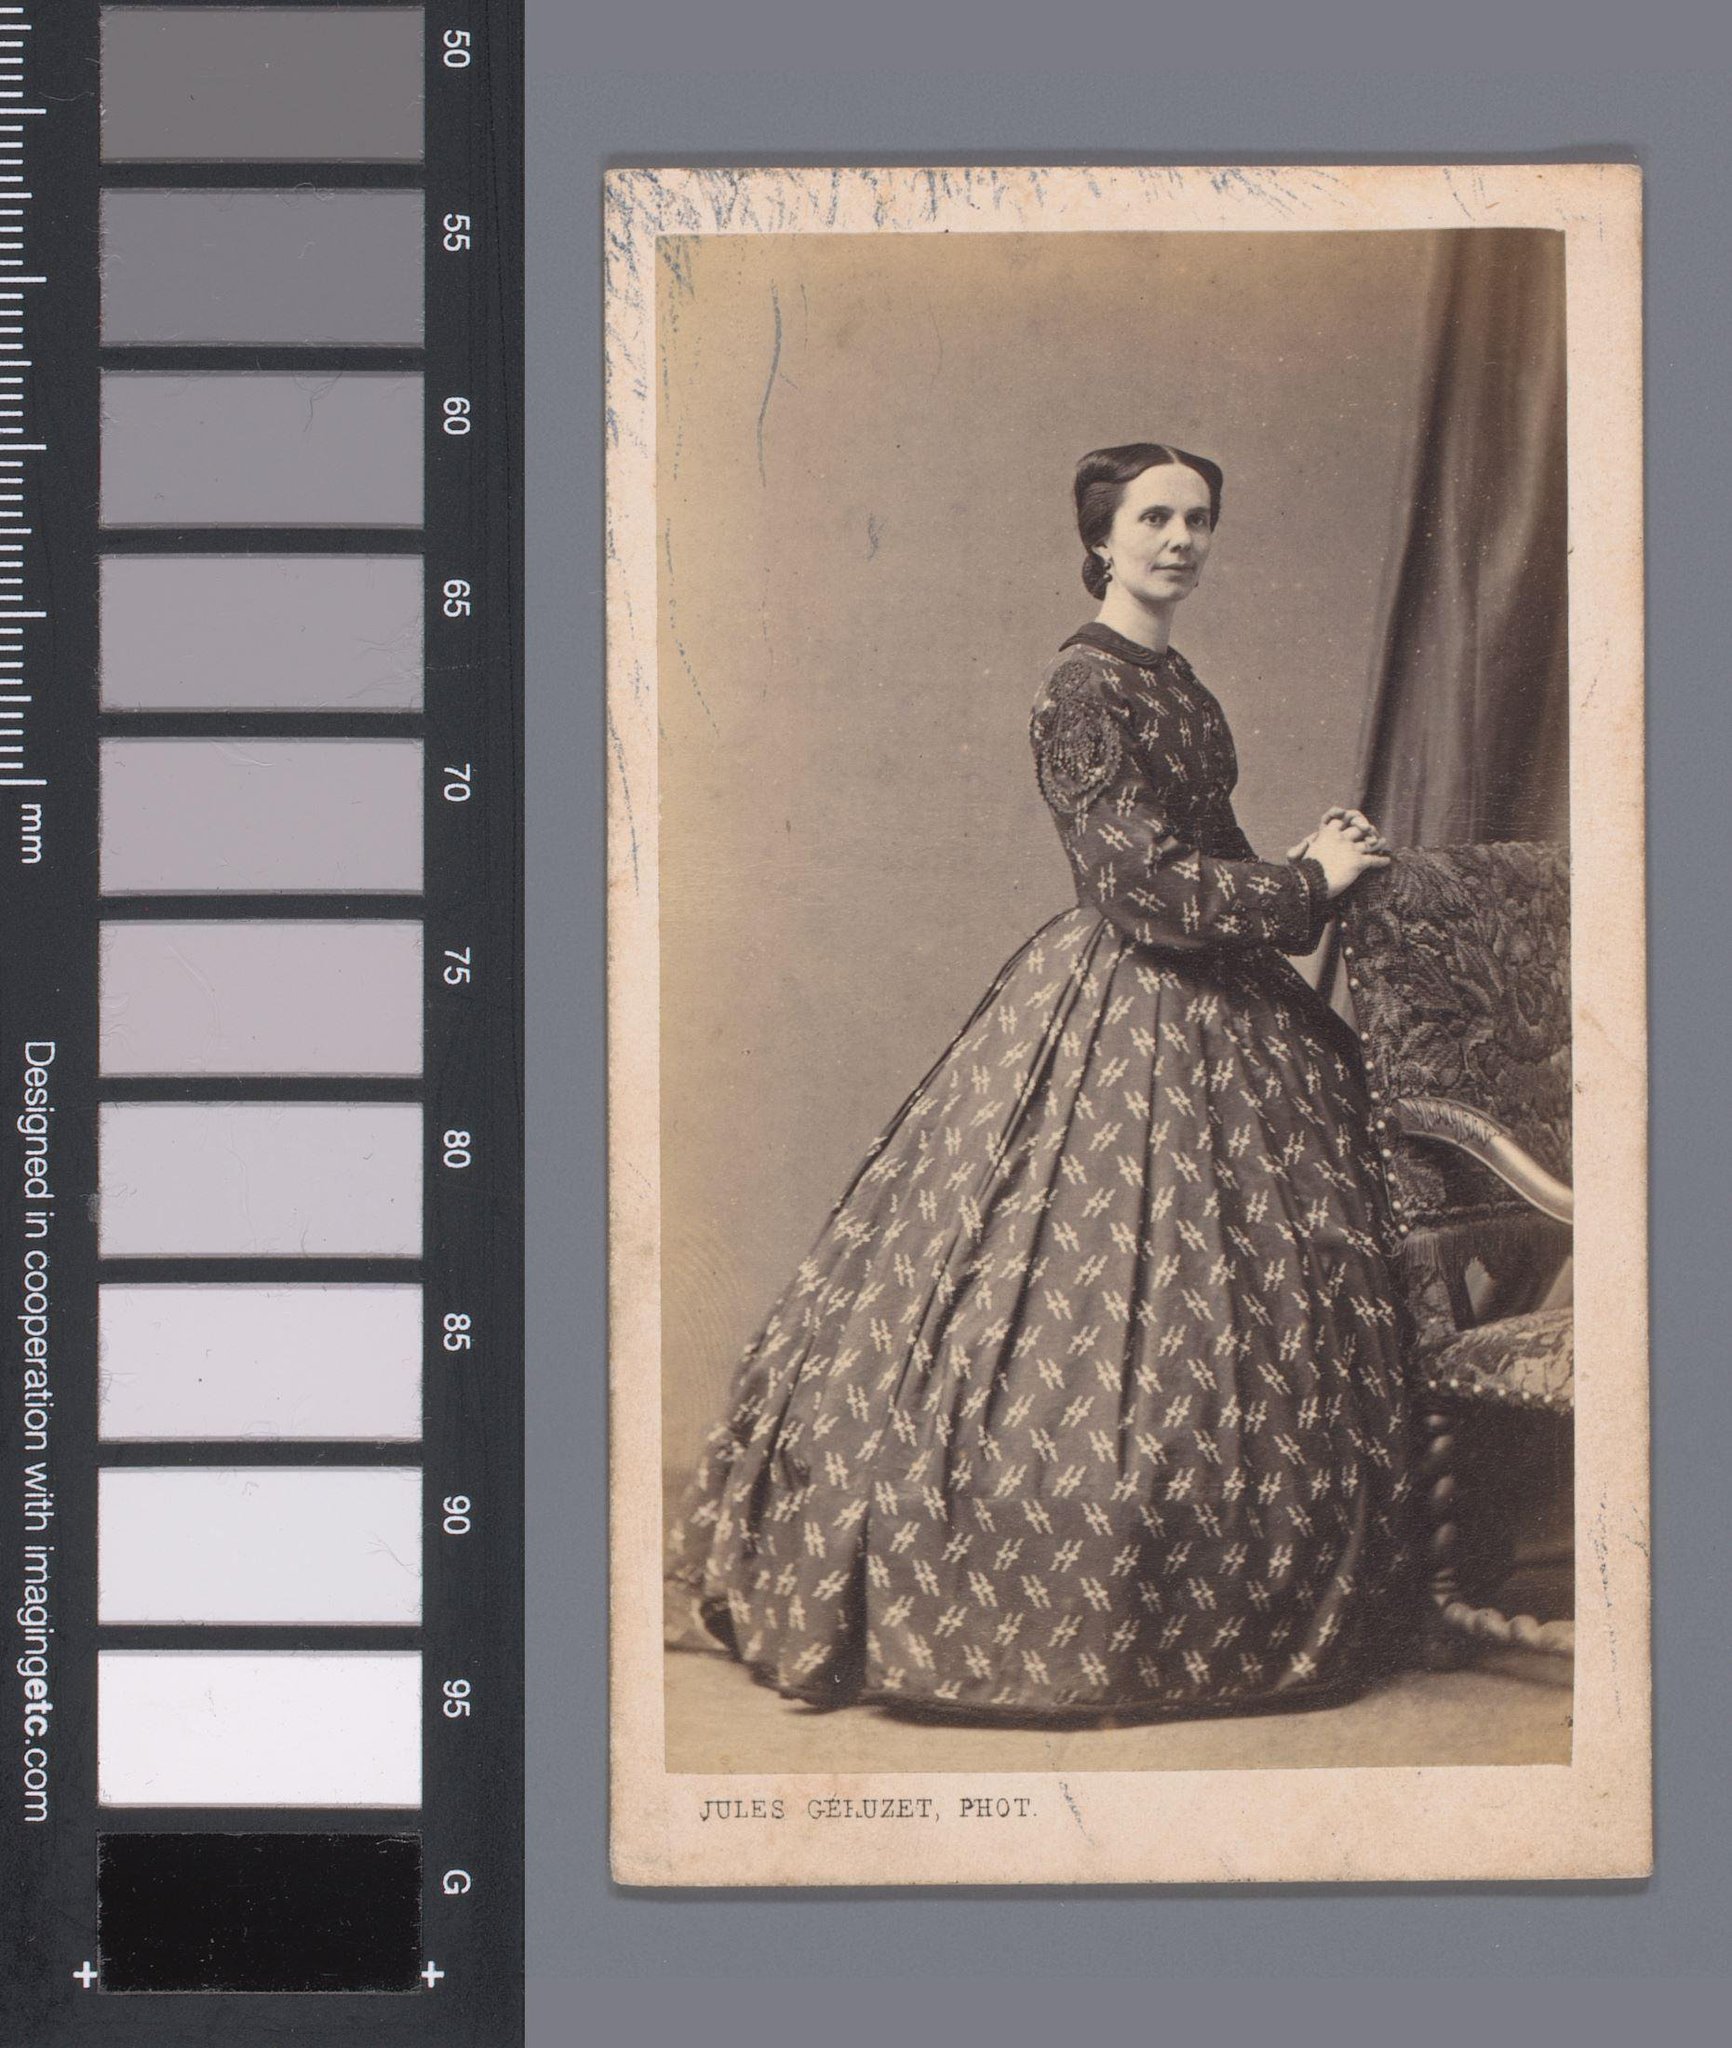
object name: photograph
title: Portret van een onbekende vrouw bij een stoel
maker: jules géruzet (fotograaf)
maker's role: fotograaf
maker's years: 1817-1874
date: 1865-1866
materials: cardboard, paper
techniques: albumen print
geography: brussels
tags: adult woman, anonymous historical person portrayed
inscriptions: address: ‘27bis rue de l'Ecuyer/ BRUXELLES’